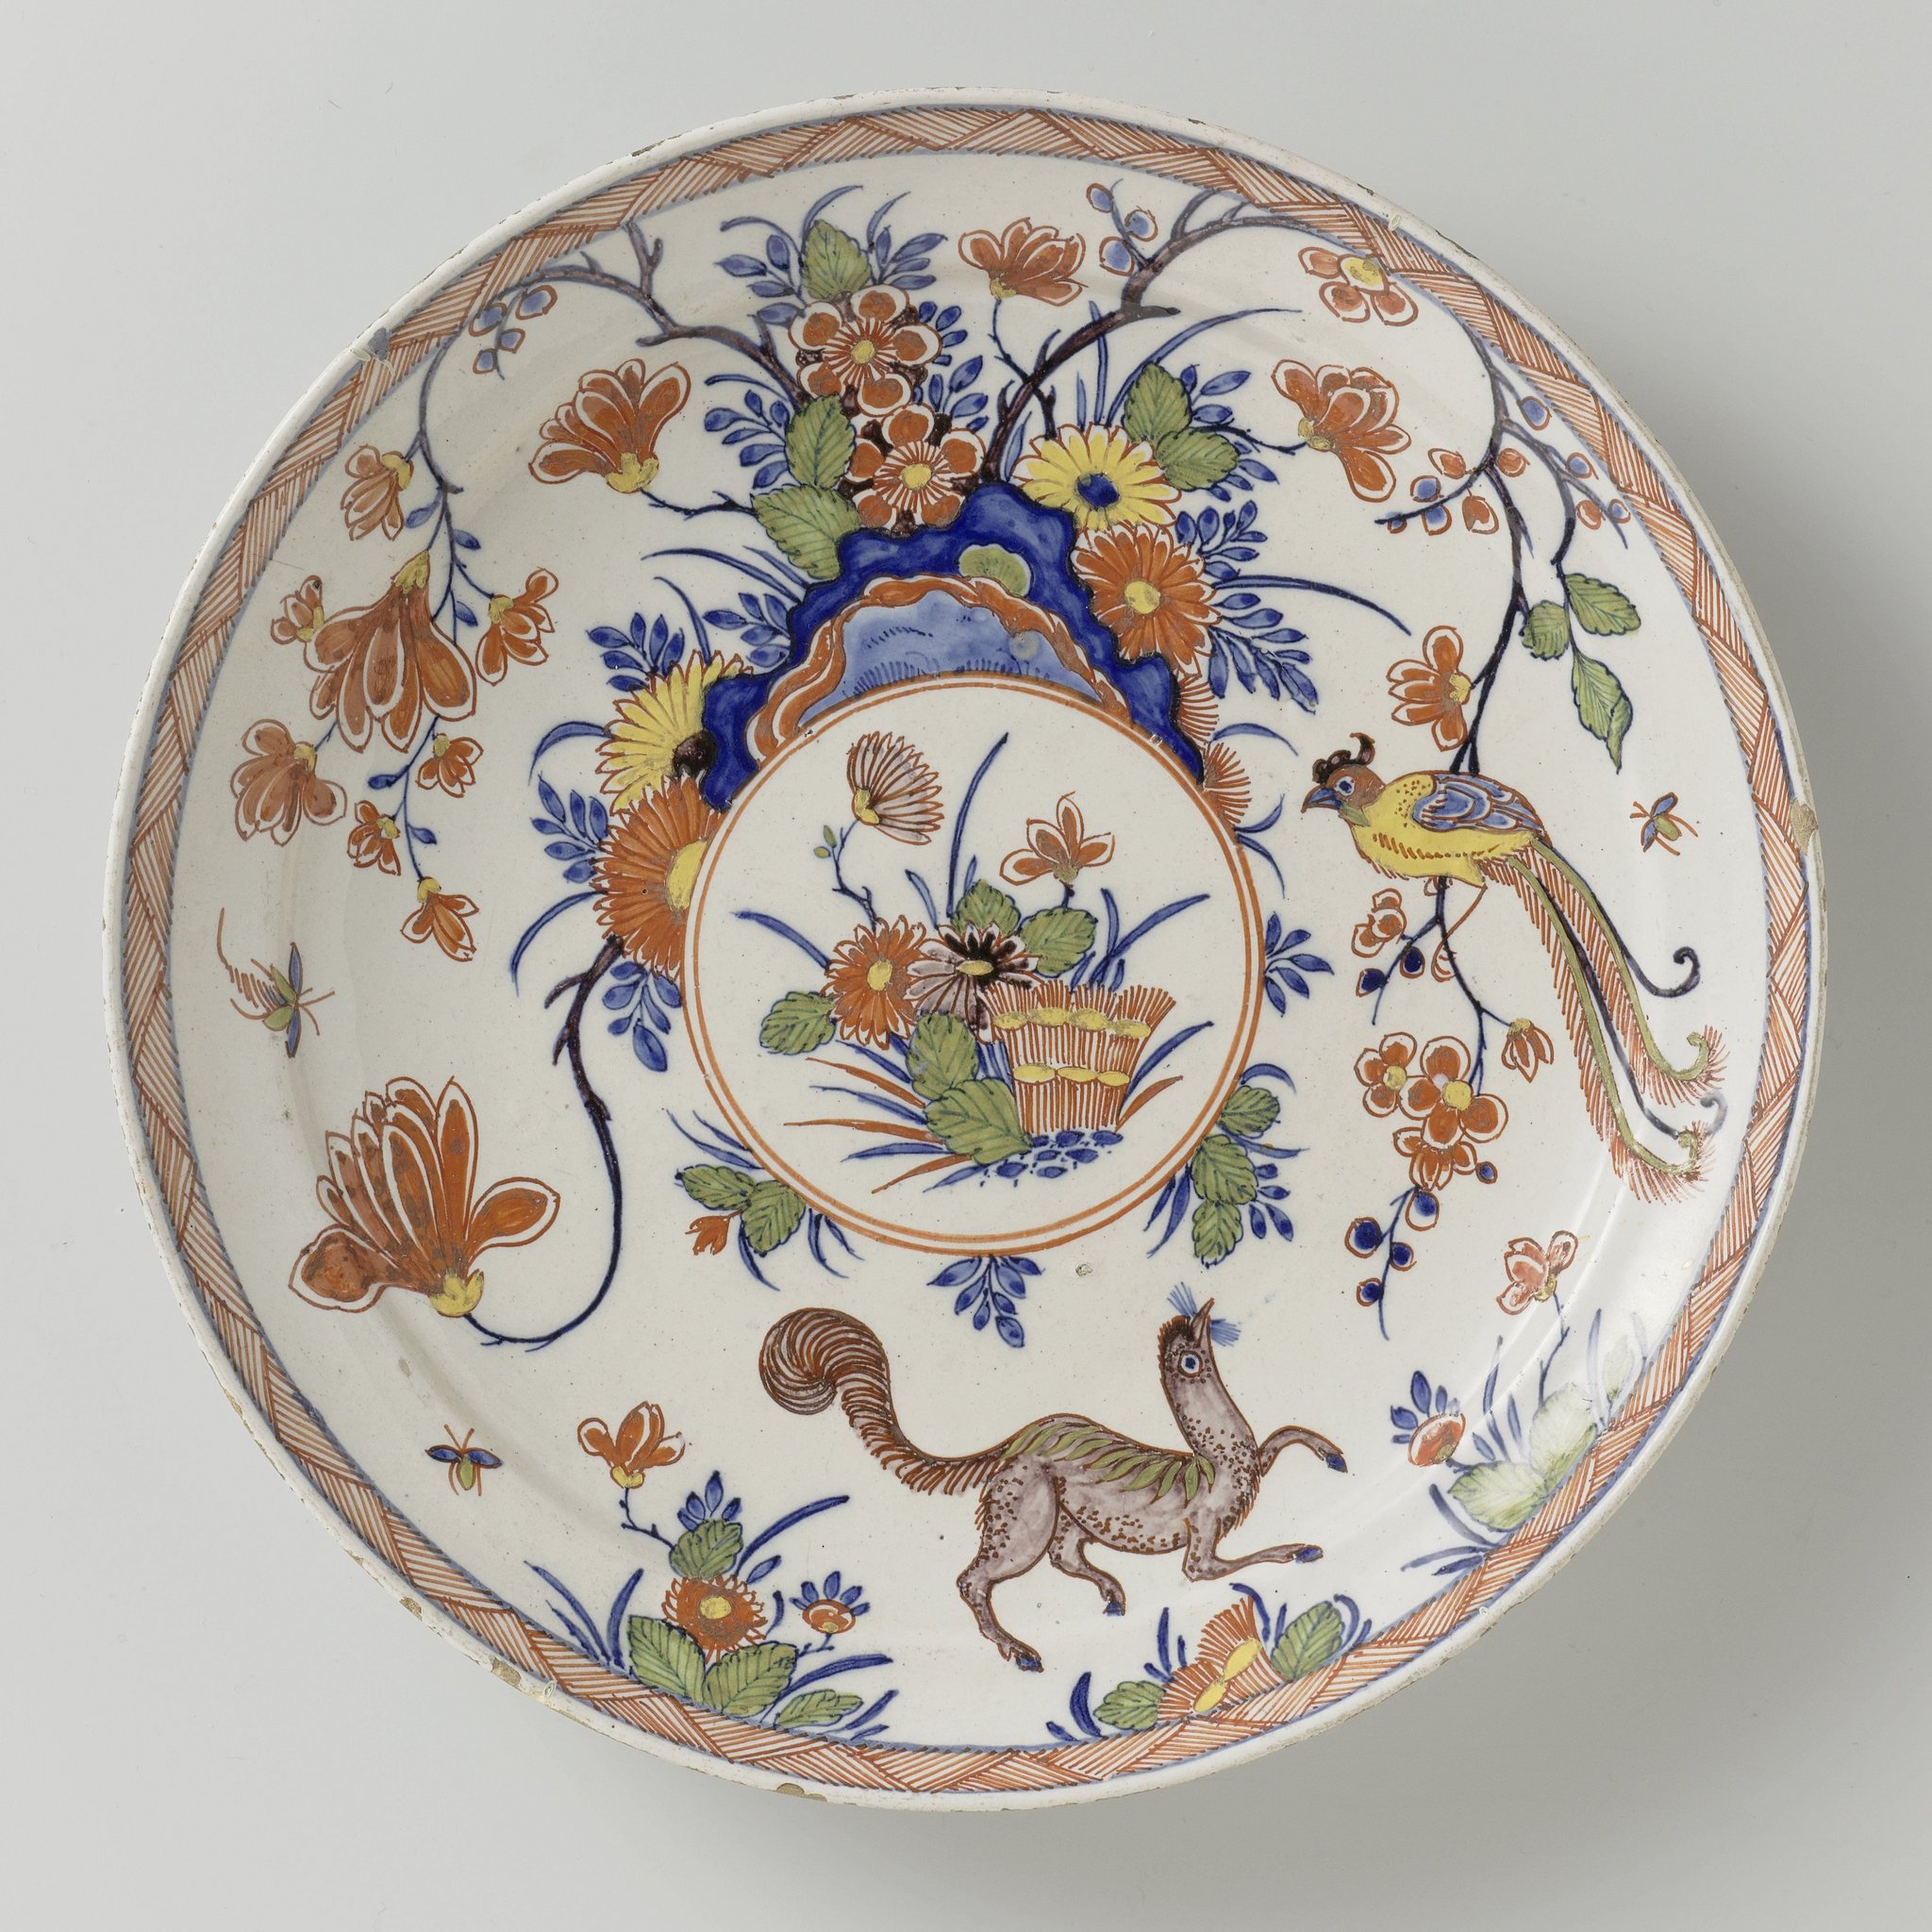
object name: plate dish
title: Bord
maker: Anonymous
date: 1710-1740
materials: faience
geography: delft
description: Bord van faience. Veelkleurig beschilderd naar Japans Kakiemon voorbeeld.